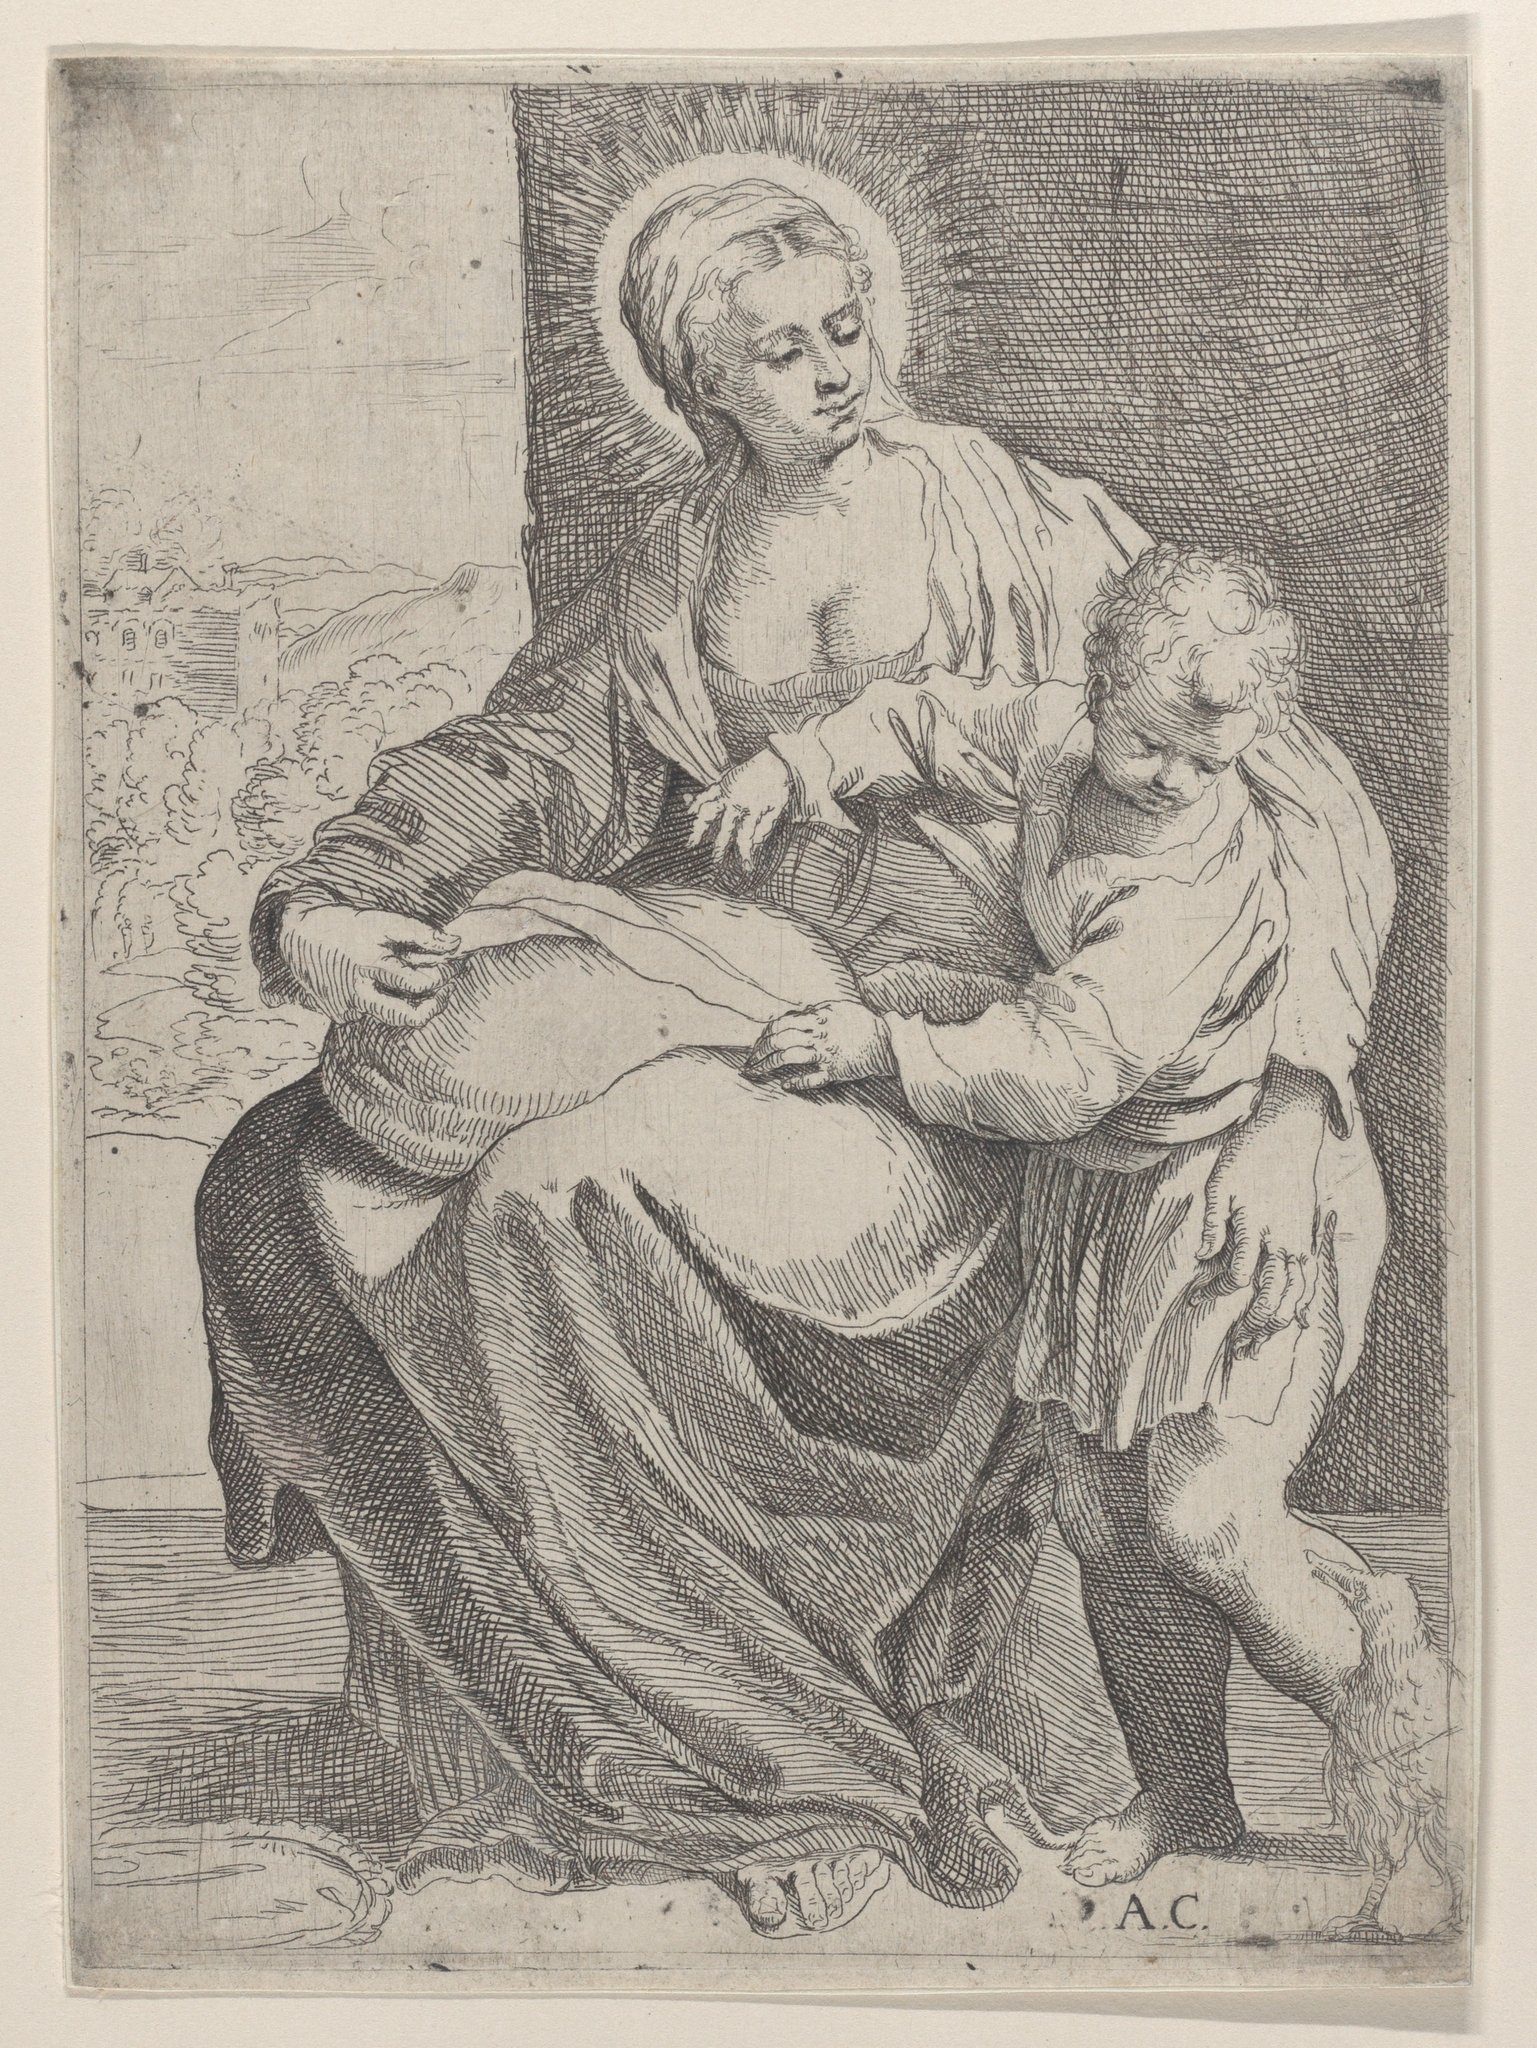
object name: print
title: The Virgin seated holding a pillow on her lap with the young Christ standing at right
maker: annibale carracci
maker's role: artist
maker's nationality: italian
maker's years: 1560-1609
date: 1580-1600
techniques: etching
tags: christ,virgin mary